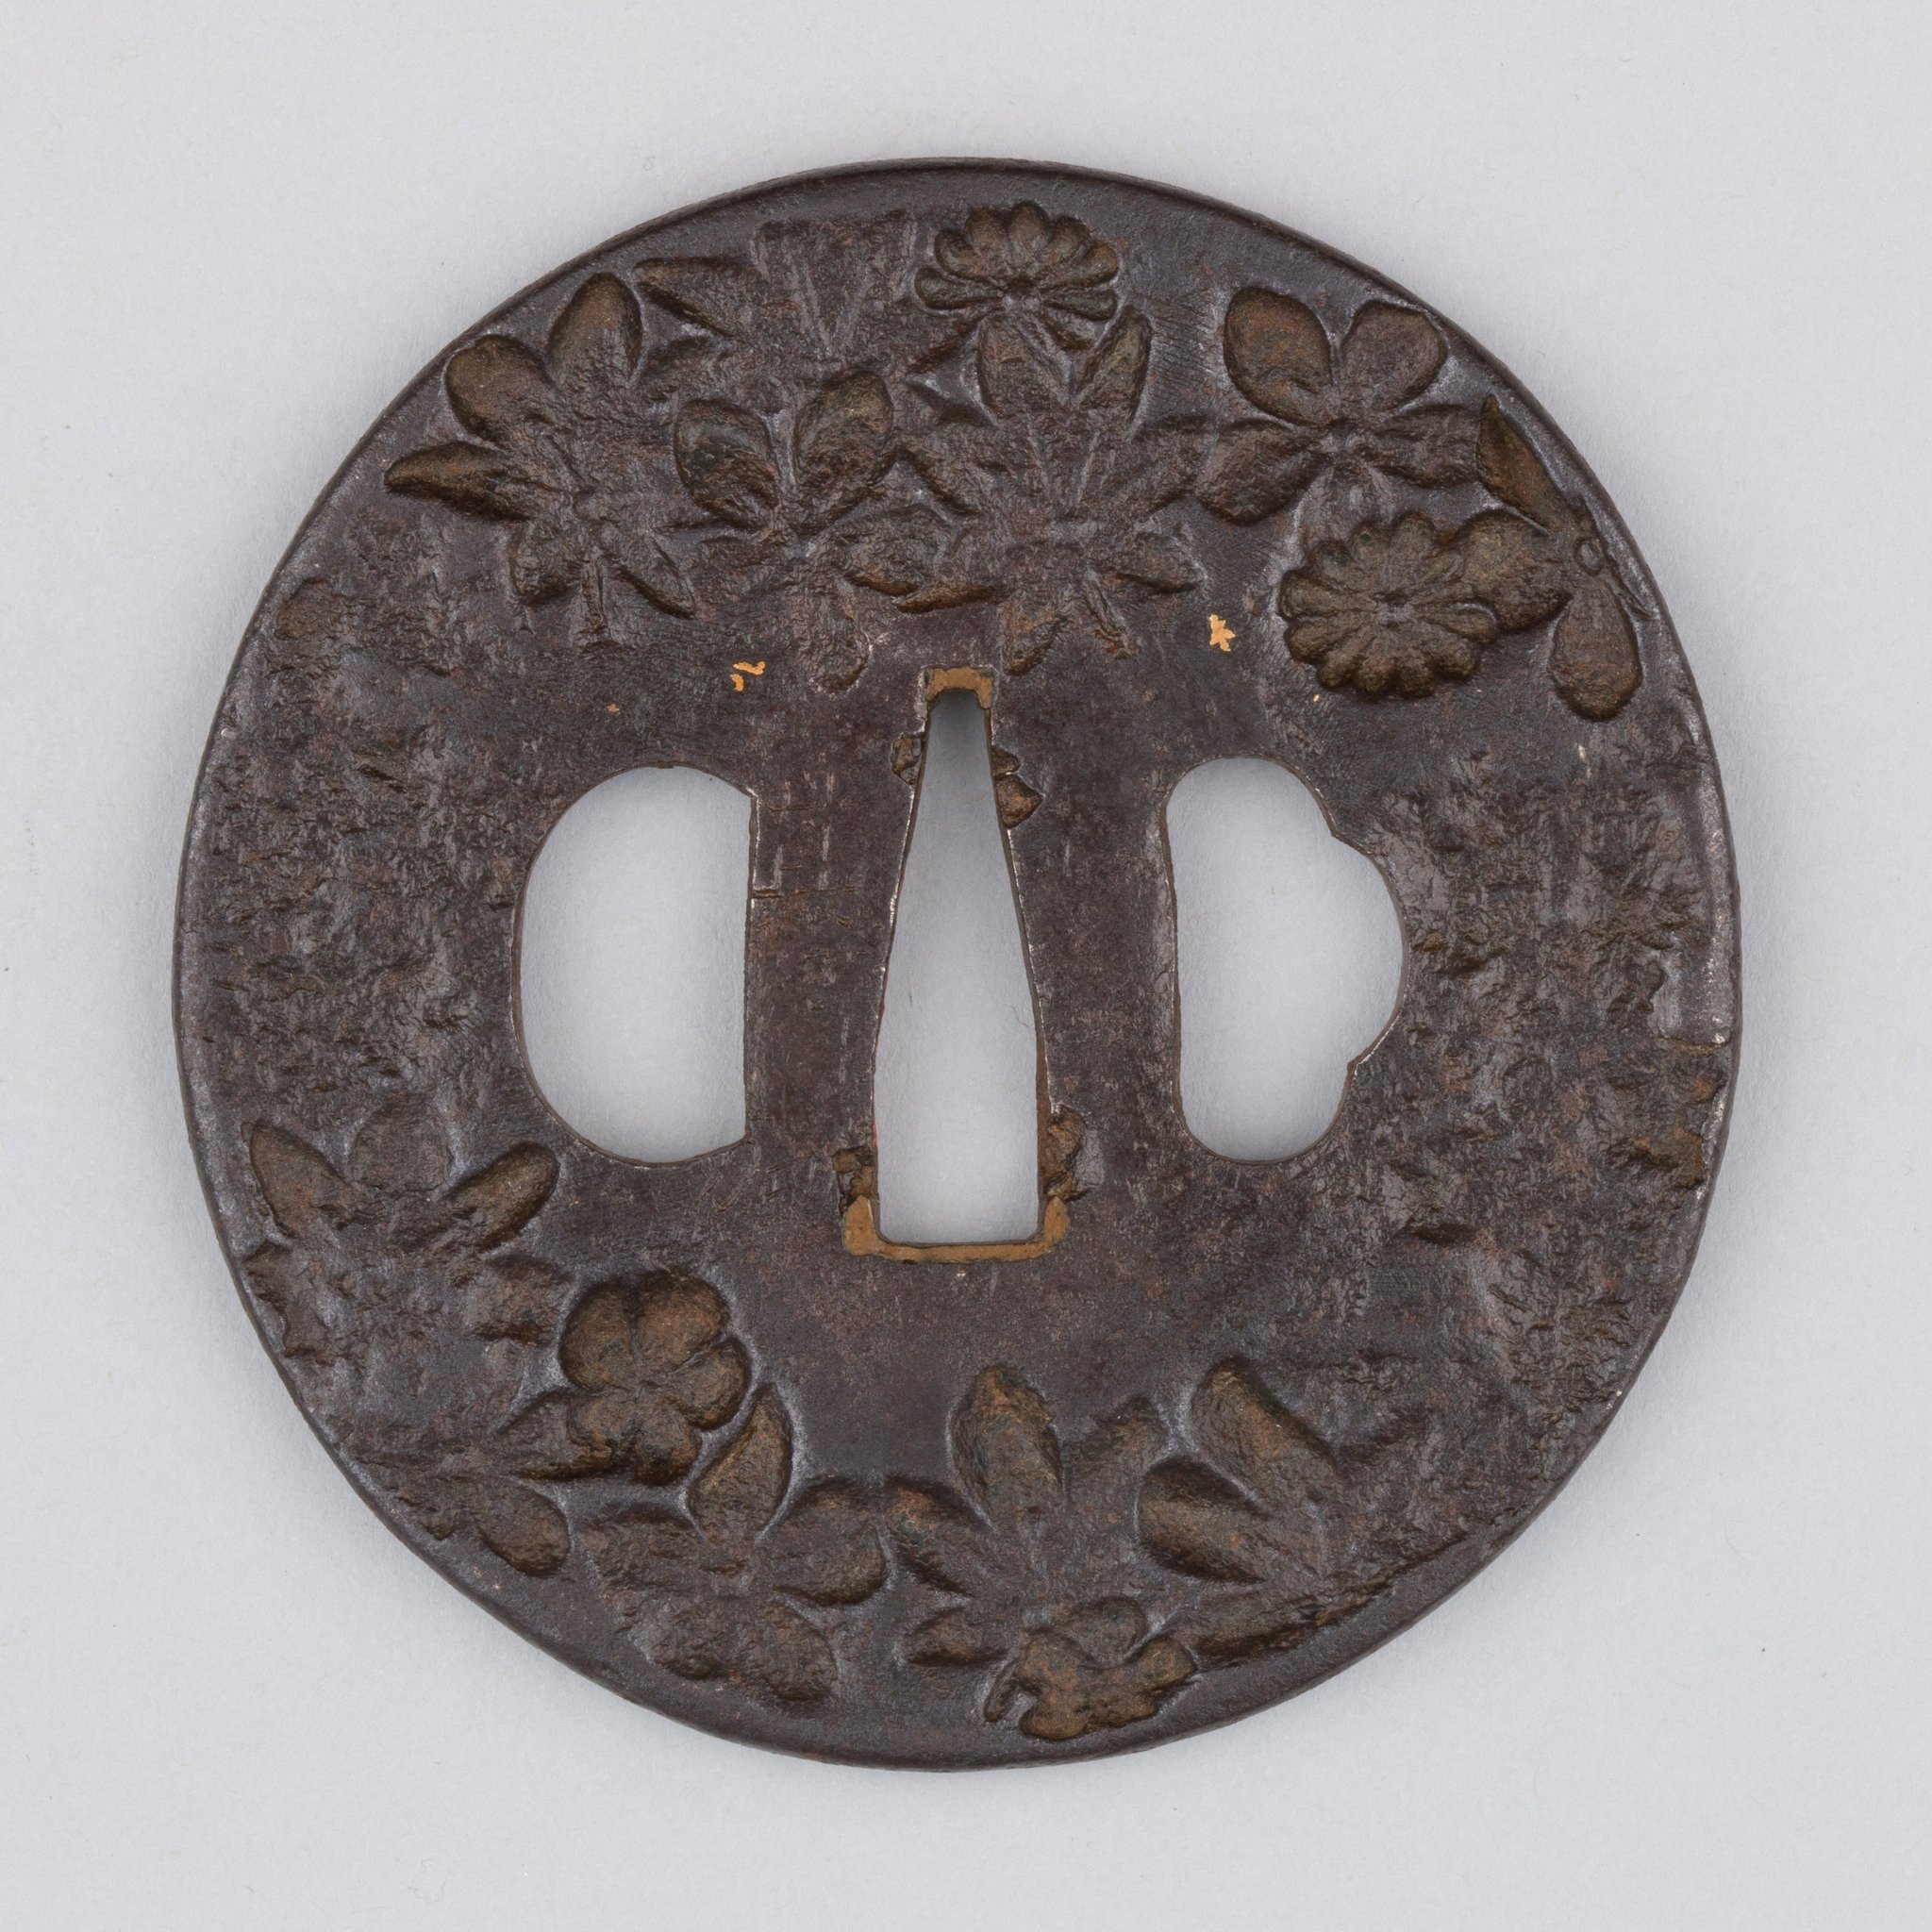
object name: sword guard tsuba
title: Sword Guard (Tsuba)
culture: japanese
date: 1667-1700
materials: copper, gold, iron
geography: japan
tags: flowers